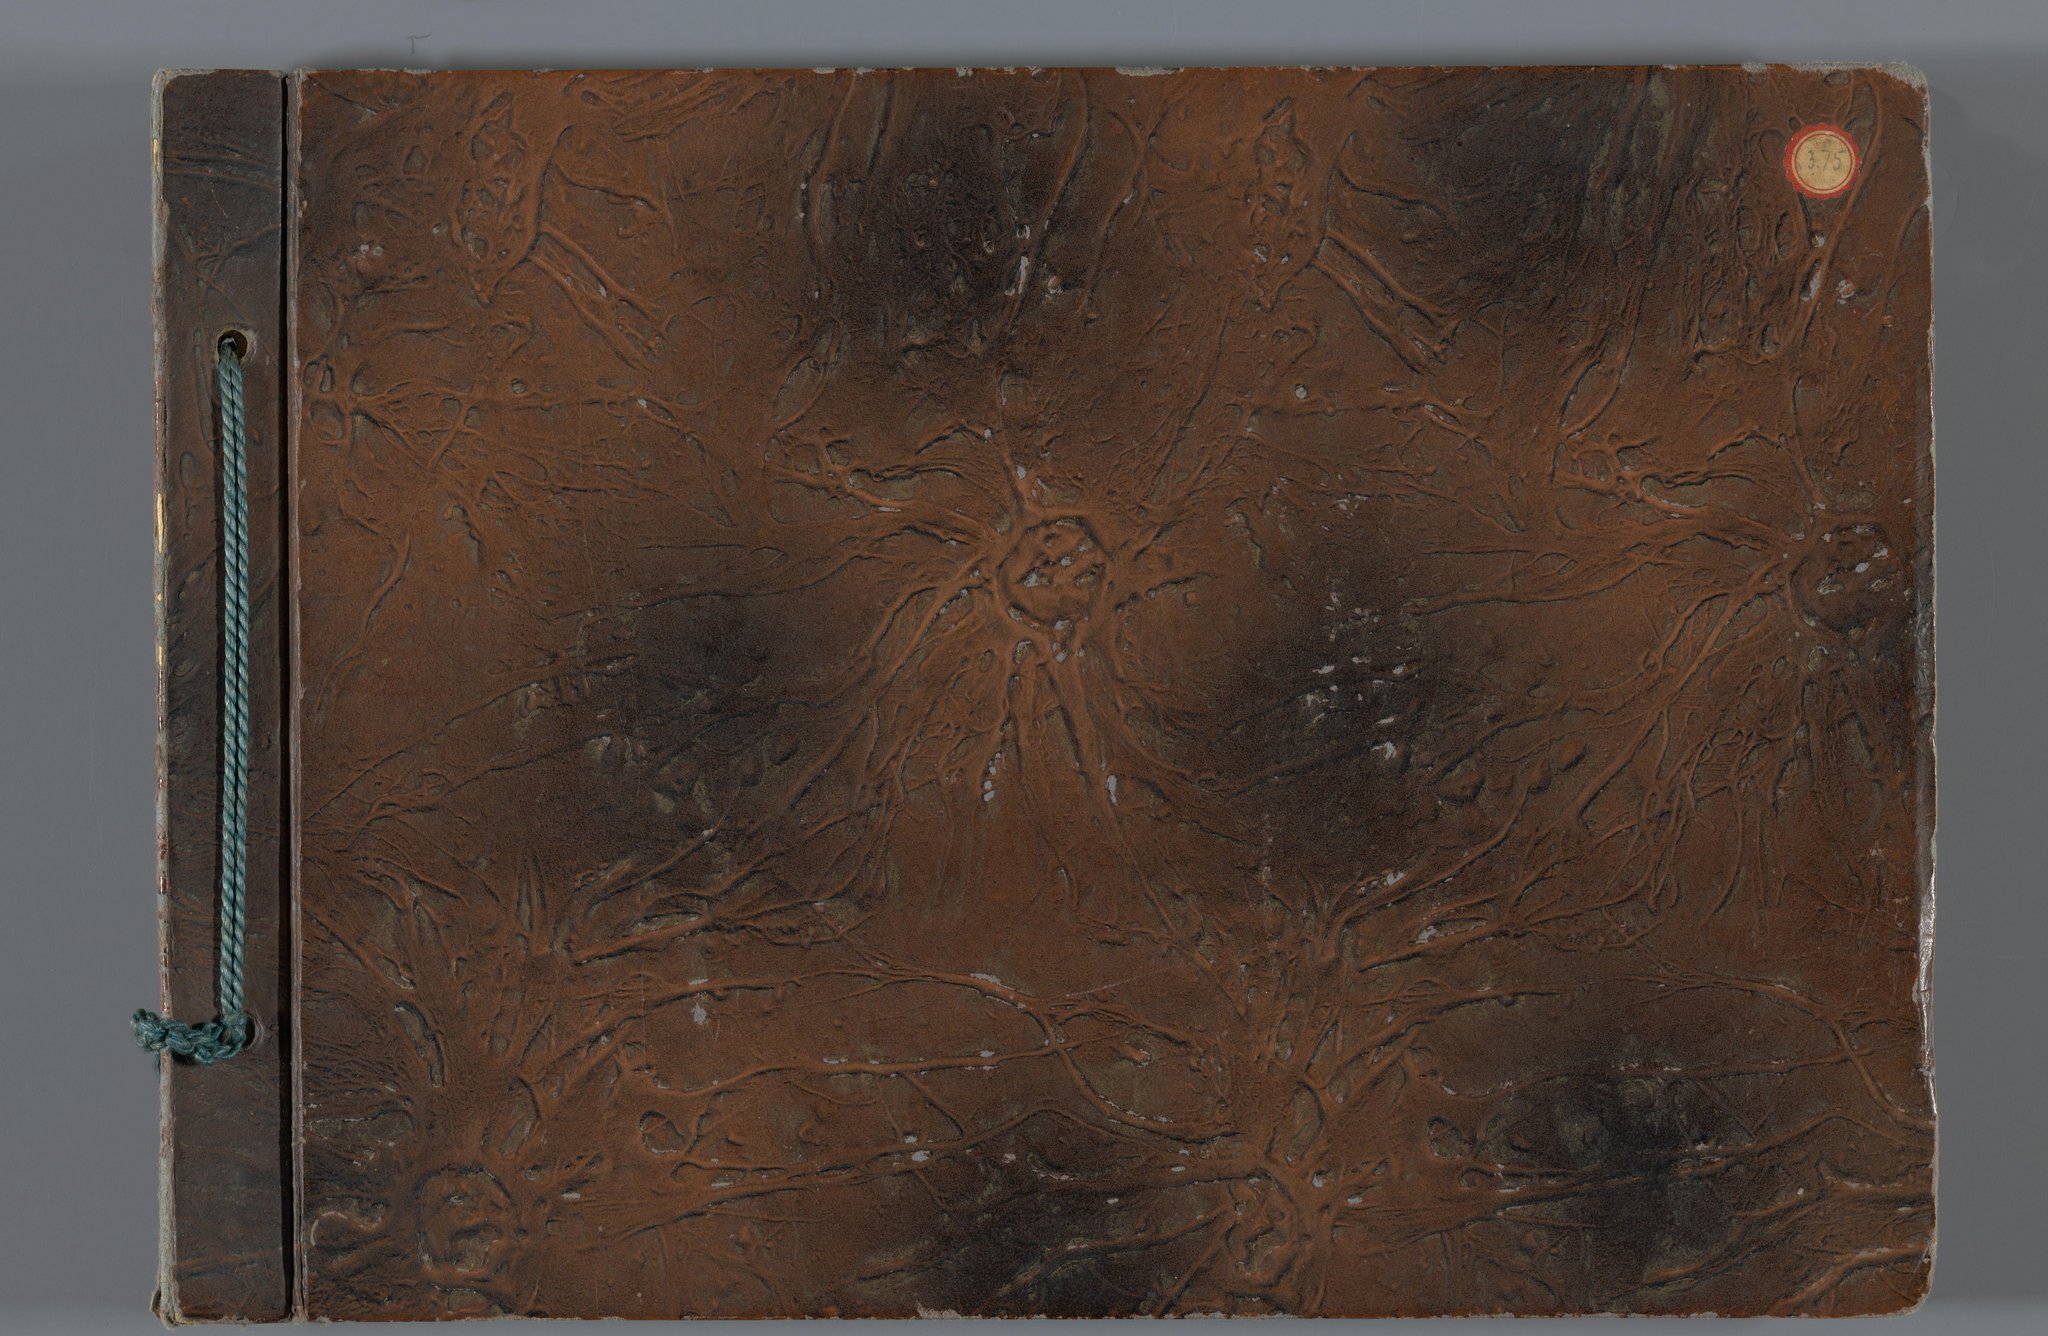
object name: photograph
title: Departure from Indonesia and boat trip to the Netherlands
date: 1923-1929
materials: cardboard, photographic support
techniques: gelatin silver print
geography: java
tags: surabaya, engineer, frédéric gabriël dumas, paris, beatrice jacqueline eveline dumas, adolescent, young woman, maiden, girl (child between toddler and youth), family life at home, dutch east indies, the, batavia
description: These album pages were owned by Eef Dumas, the daughter of a hydraulic engineer. In her childhood she travelled back and forth between Semarang where her family lived and The Hague where she attended school for a few months every year. In 1933 she left to the Netherlands. She went to read law in Leiden and married the writer Max Nord.